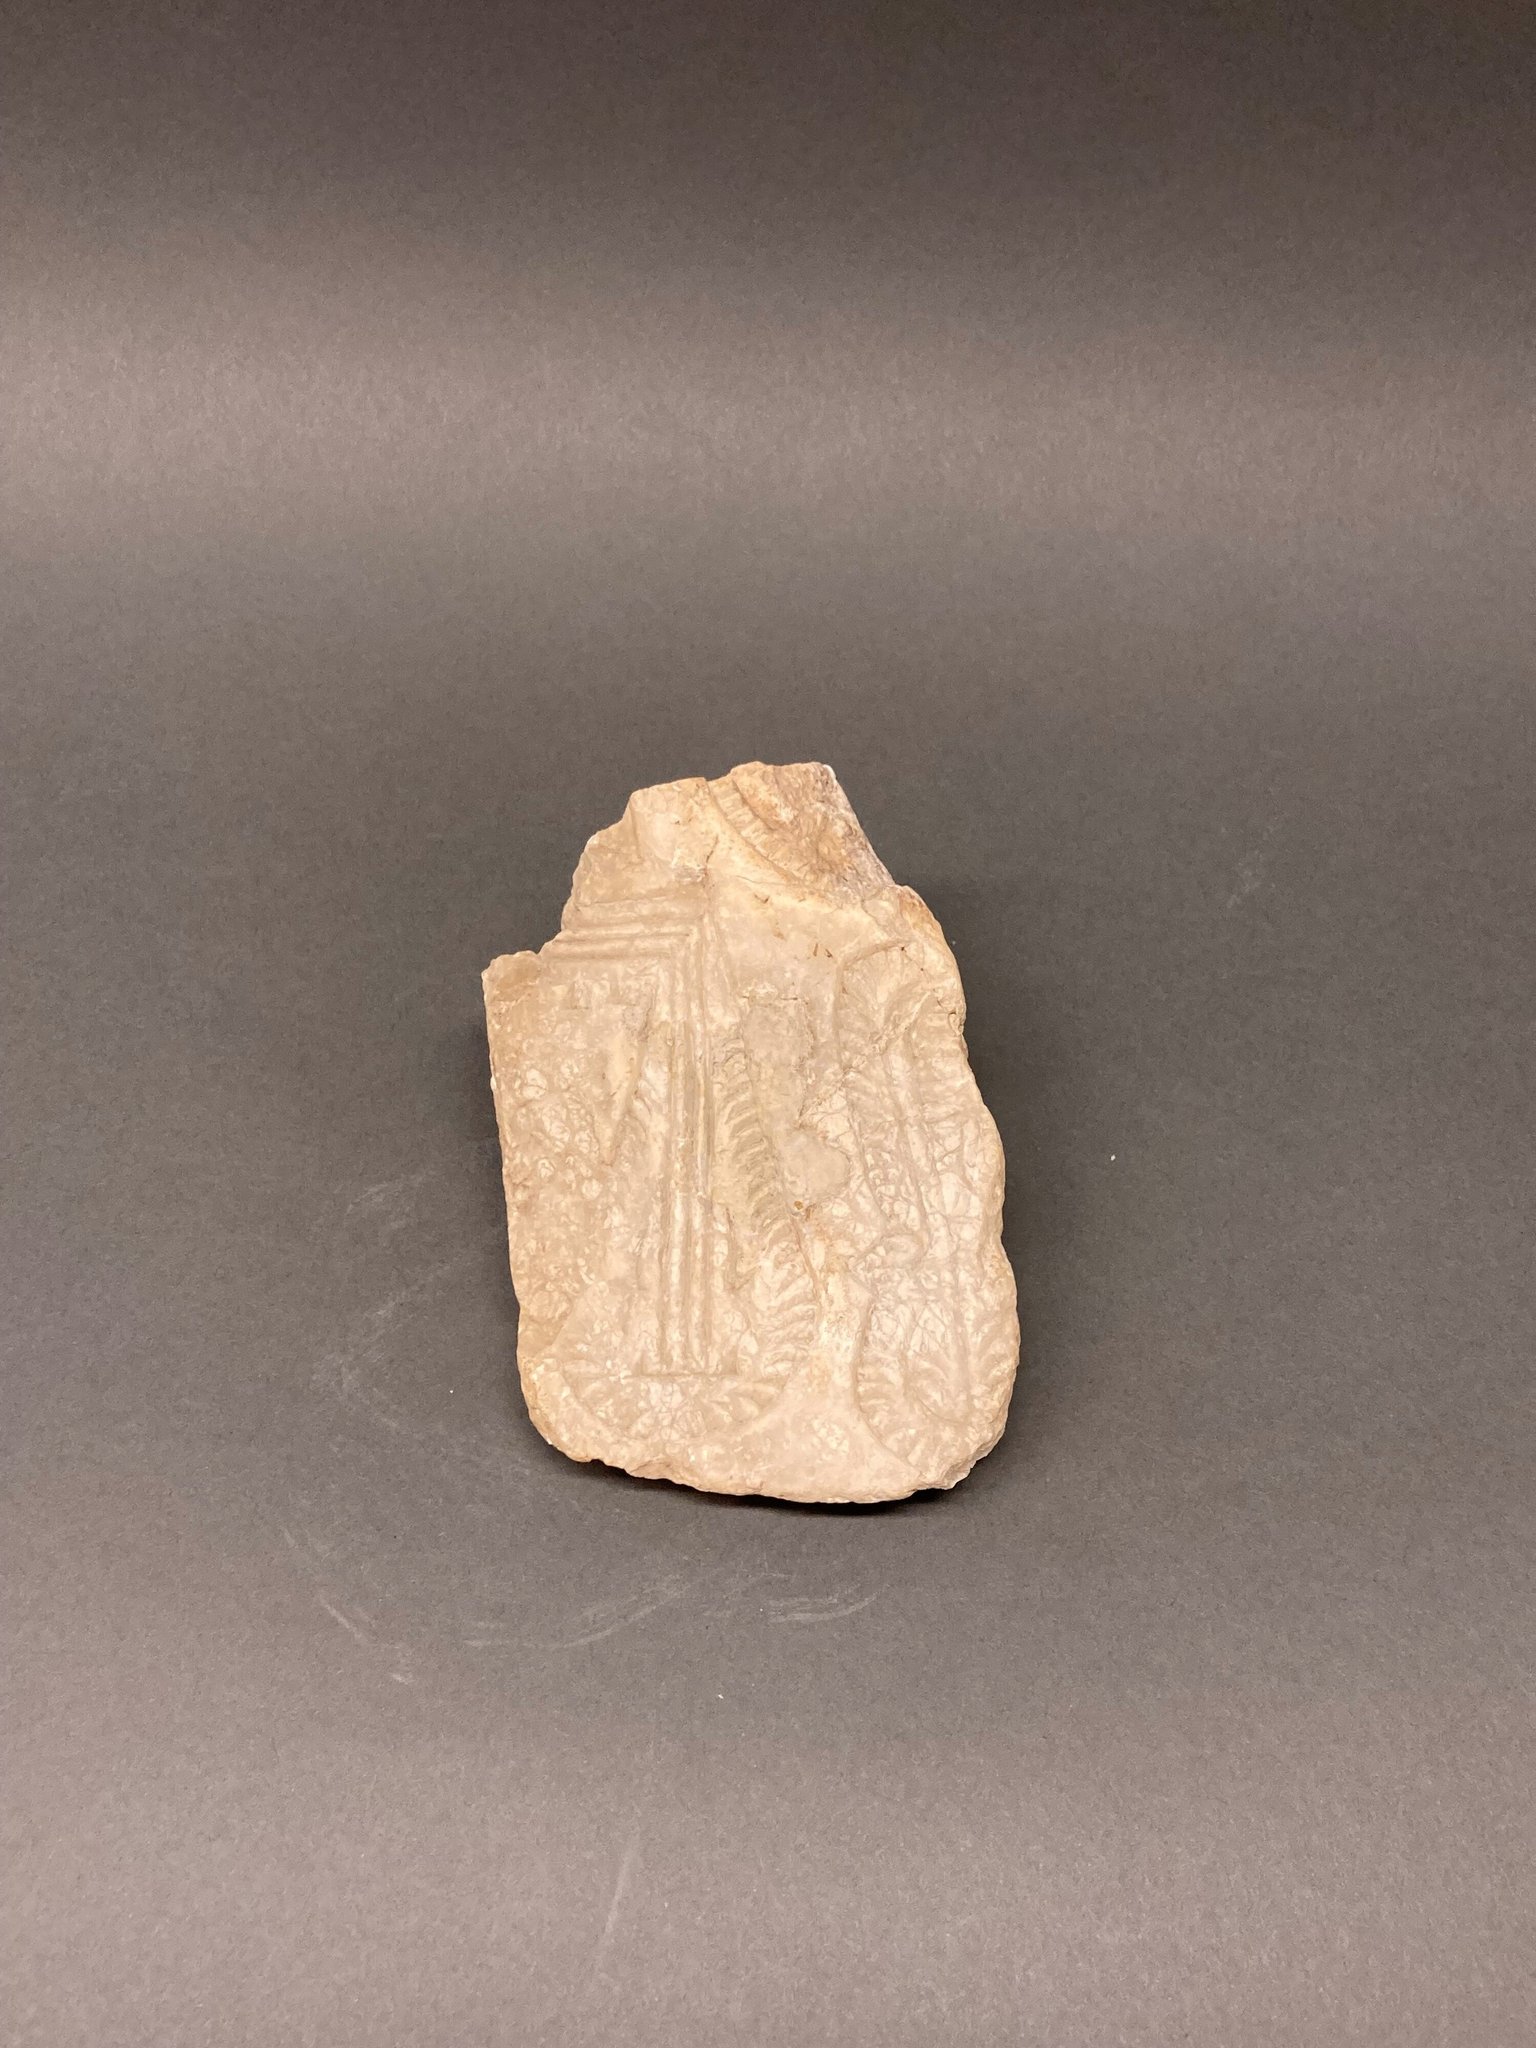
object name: fragment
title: Fragment of Tombstone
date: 801-1100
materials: limestone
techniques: carving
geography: iran